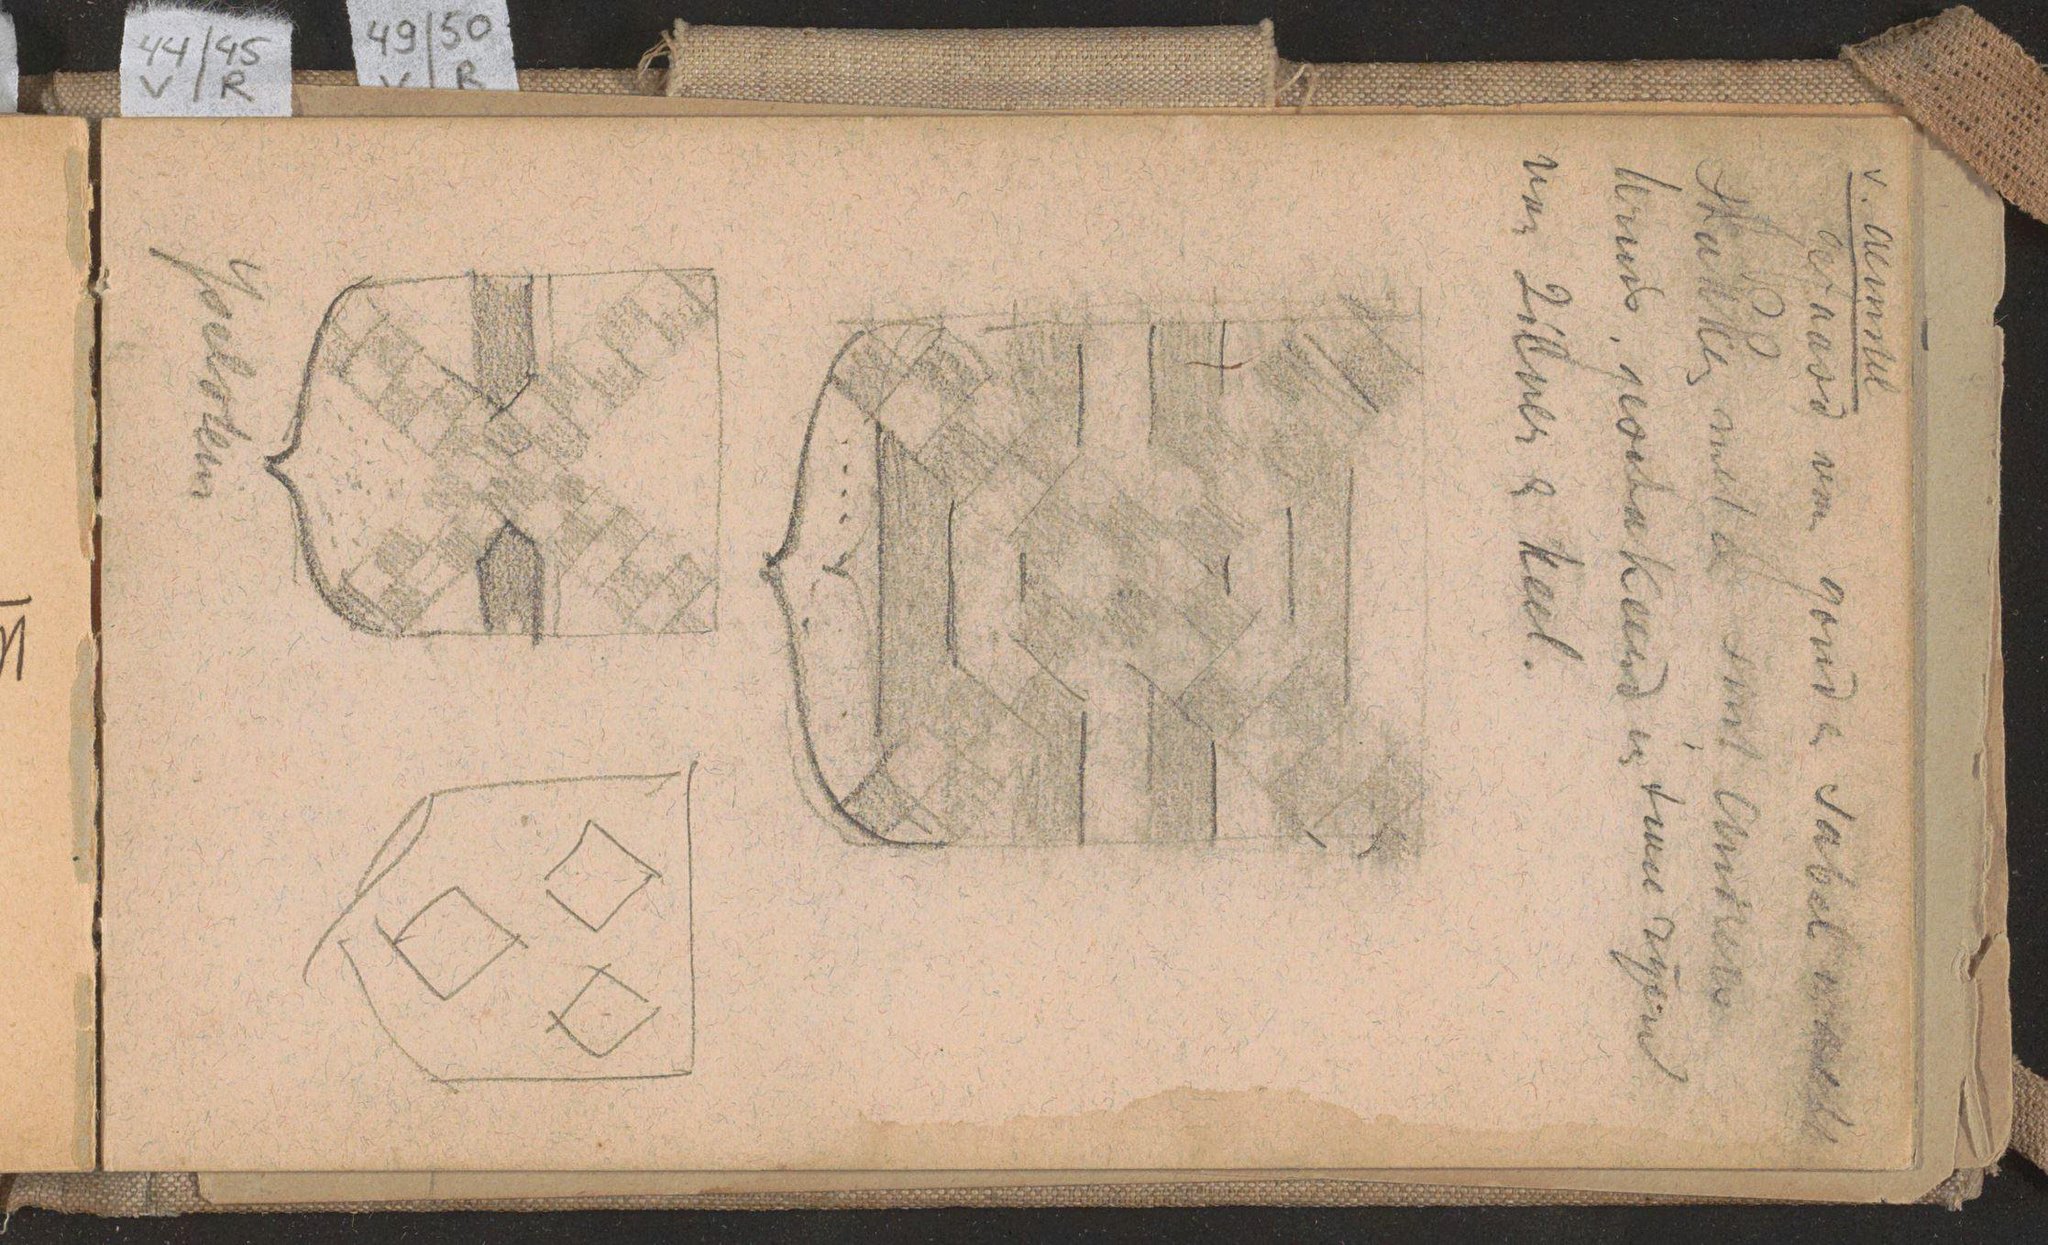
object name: sketchbook leaf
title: Familiewapen van Van Aemstel en het gemeentewapen van IJsselstein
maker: antoon derkinderen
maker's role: draughtsman, painter, print maker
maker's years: 1859-1925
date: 1892-1901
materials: paper, pencil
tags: coat of arms (as symbol of the state, etc.) (+ city; municipal), armorial bearing, heraldry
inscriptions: annotation: ‘v. aemstel/ Ysselstein’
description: Blad 43 recto uit een schetsboek met 51 bladen.